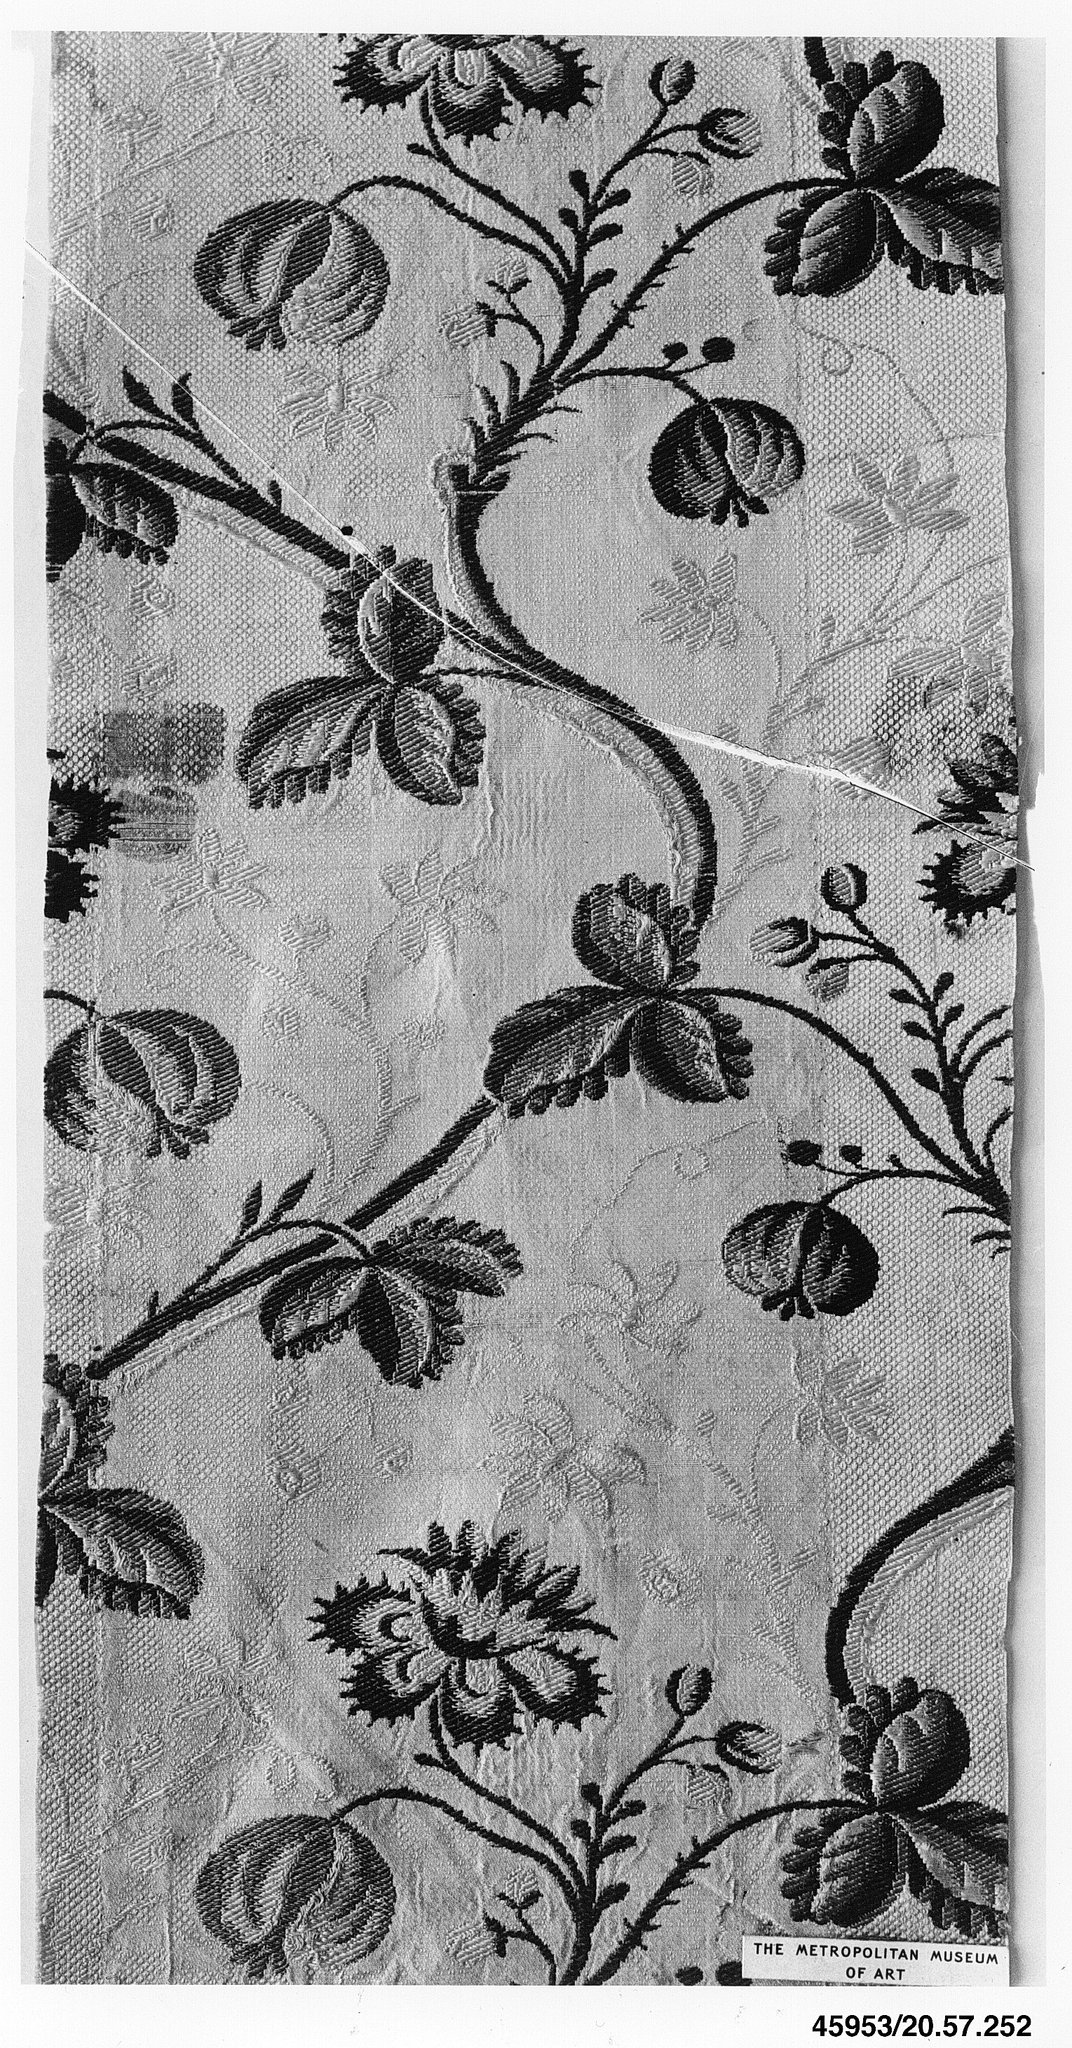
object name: piece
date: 1750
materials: silk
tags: flowers,leaves